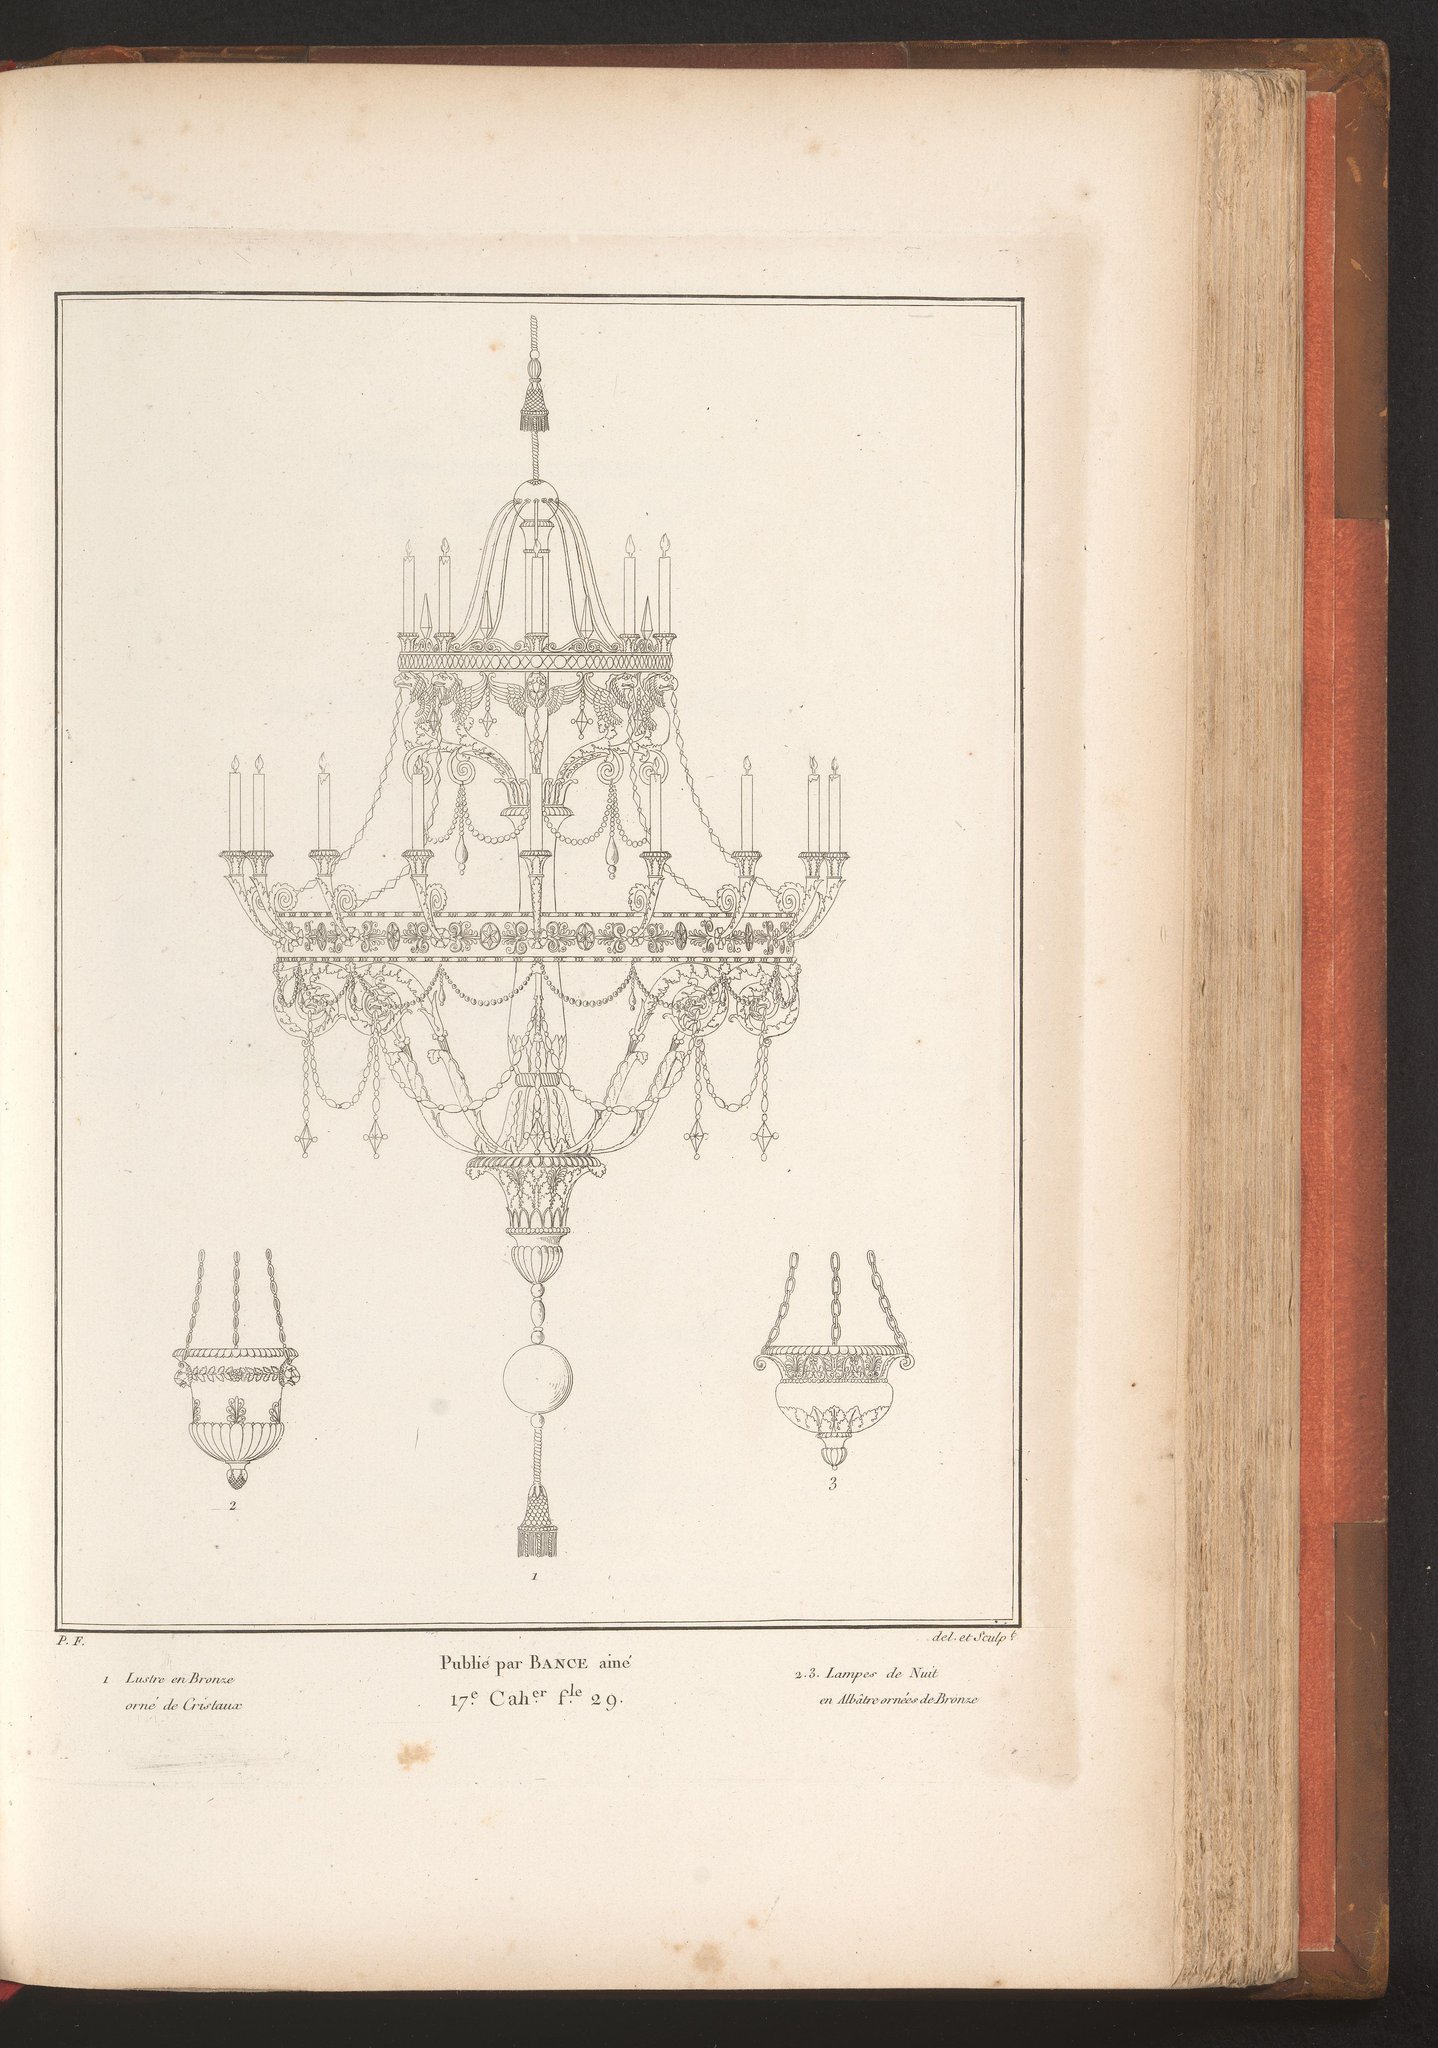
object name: ornament print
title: Kroonluchter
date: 1820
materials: paper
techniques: etching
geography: paris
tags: ornaments ~ art, chandelier, candelabrum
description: Ornamentprent met een kroonluchter en twee hanglampen. Onderdeel (17e. Cah.er f.le 29) van het prentalbum met twee series van in totaal 138 ornamentprenten door Beauvallet en Normand, 'Fragmens d'Ornemens dans le Style Antique'.